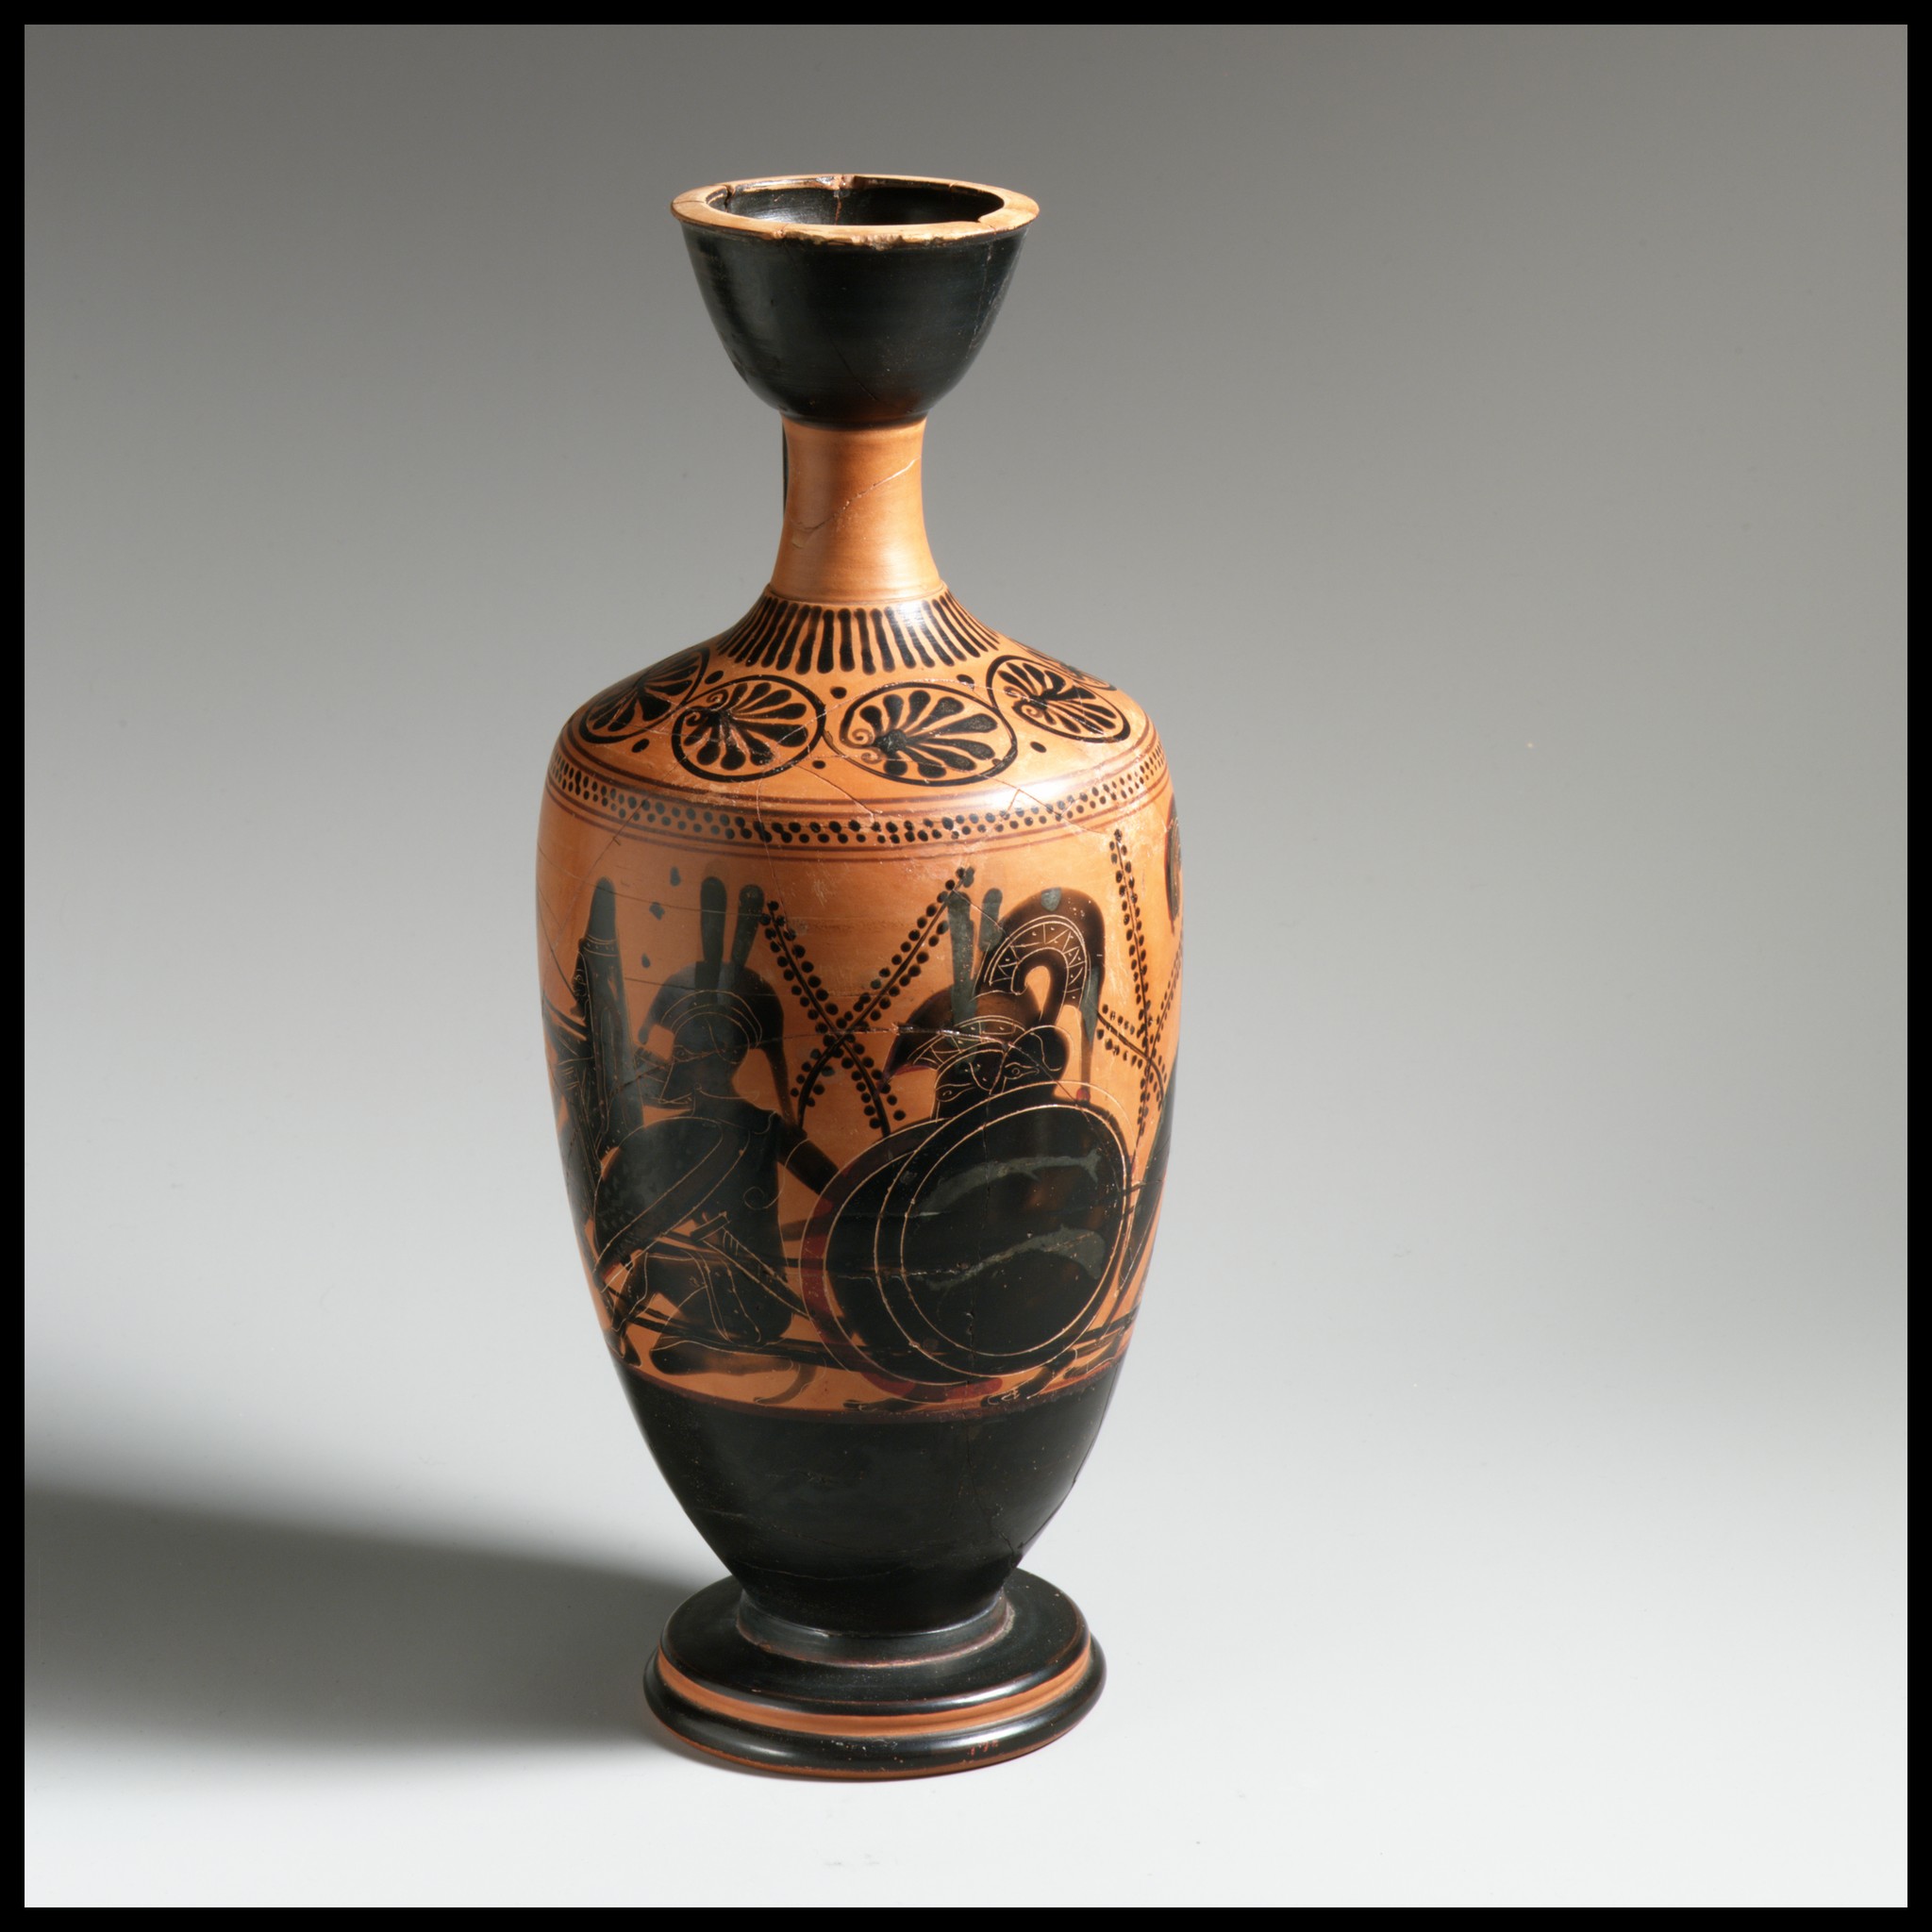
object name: lekythos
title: Terracotta lekythos (oil flask)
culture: greek, attic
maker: painter of vatican g.49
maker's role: artist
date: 534-468 BCE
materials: terracotta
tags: soldiers,shields